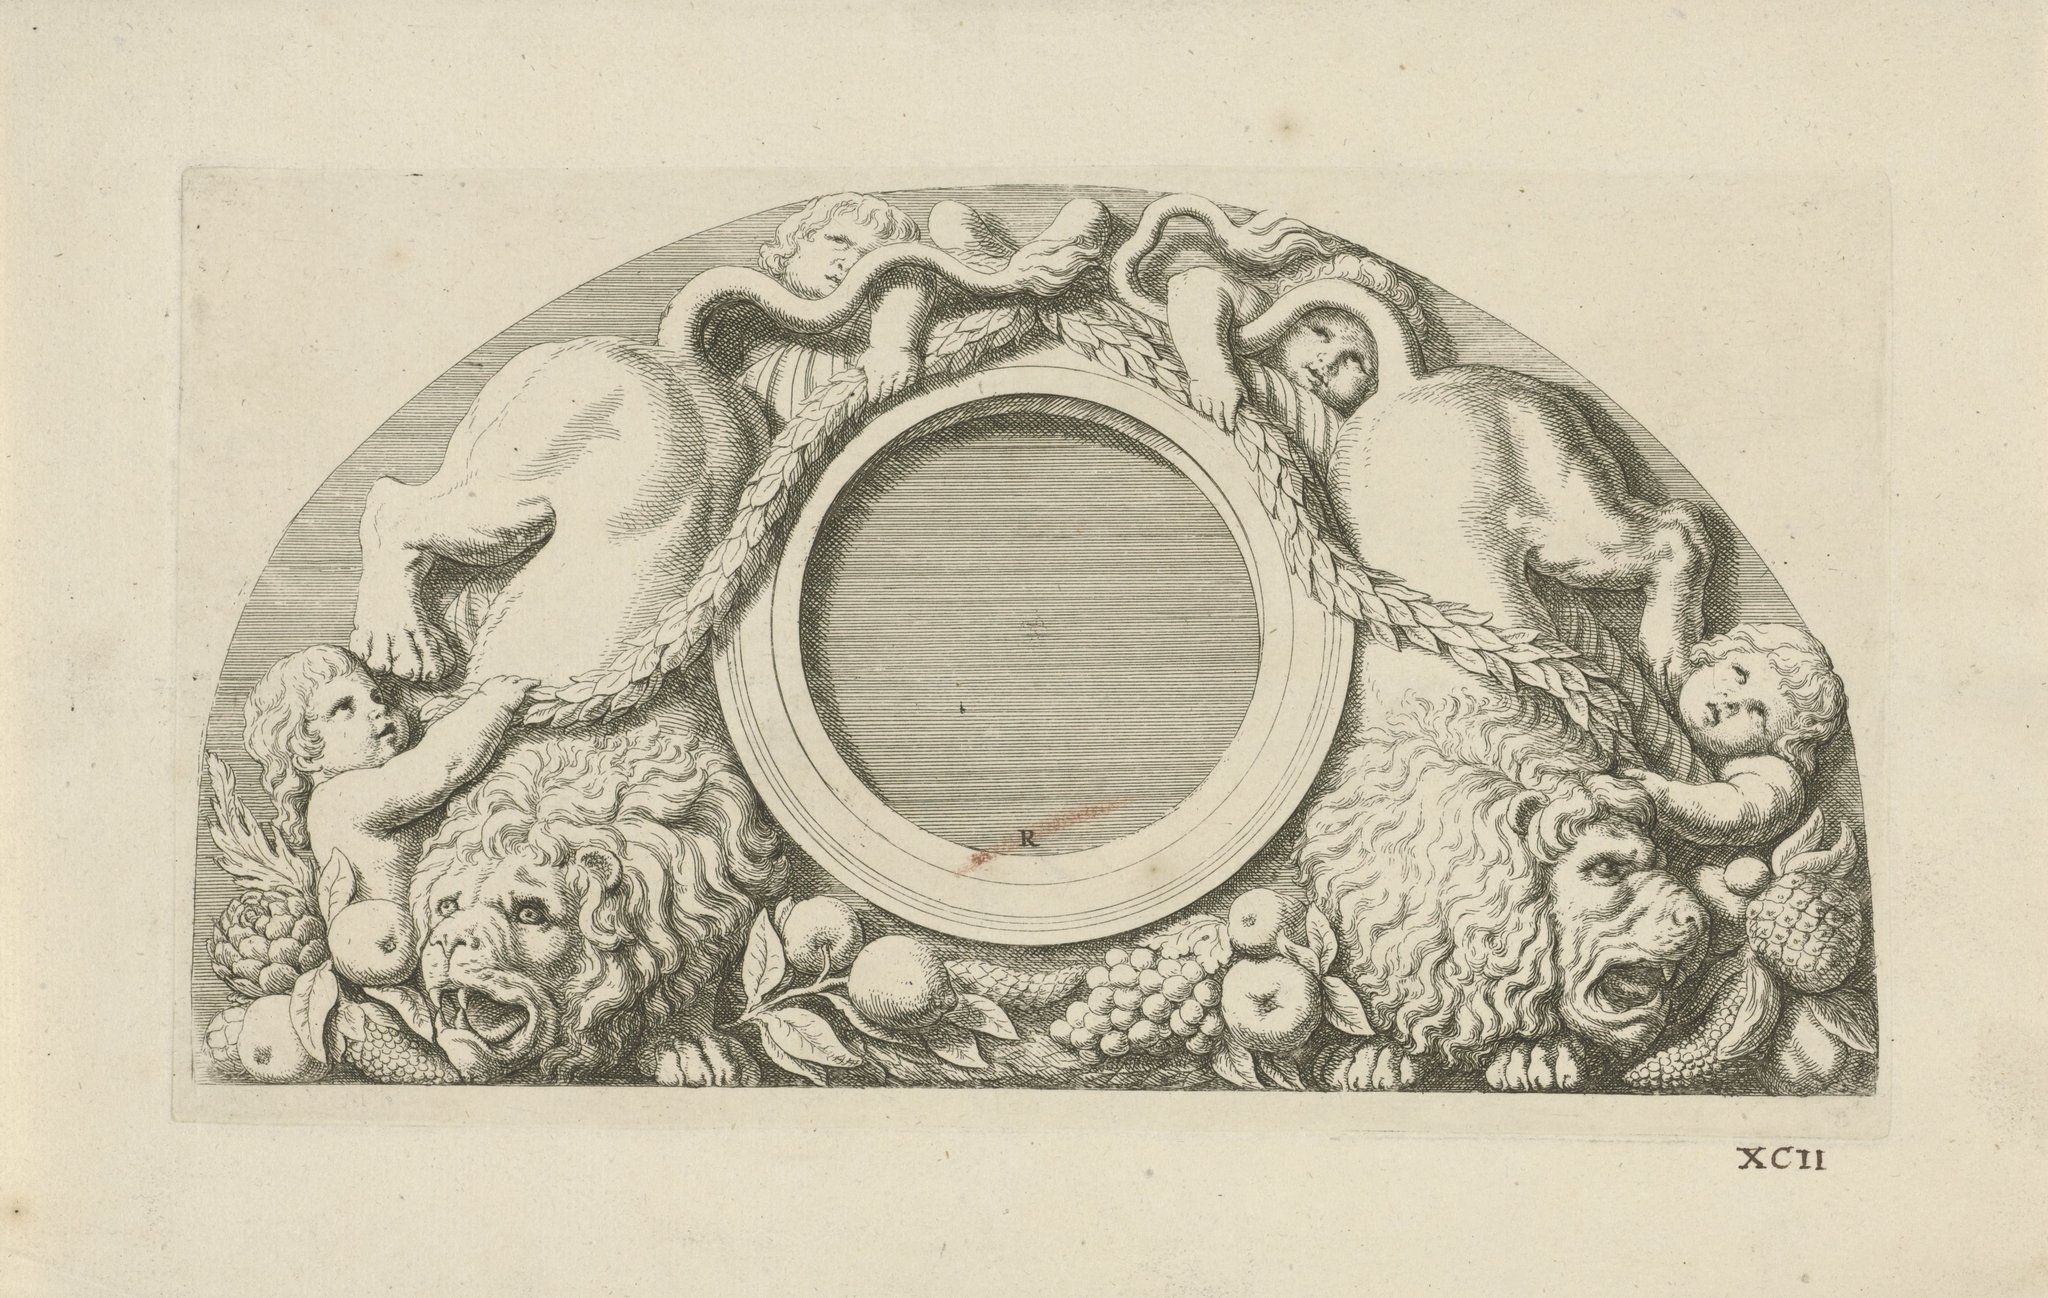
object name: print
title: Lunette met putti, leeuwen en hoornen des overvloeds in de oostelijke galerij van het Stadhuis op de Dam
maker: hubert quellinus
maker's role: print maker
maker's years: 1619-1687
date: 1655-1665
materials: chalk, ink, paper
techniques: engraving, etching, pen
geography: amsterdam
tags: 'cornucopia', horn of plenty, beasts of prey, predatory animals: lion, cupids: 'amores', 'amoretti', 'putti', attributes of cybele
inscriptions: inscription: ‘XCII’, collector's mark: Lugt 2228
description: Huidige staat van prent ook gebruikt in: Prima pars. Praecipuarum effigierum ac ornamentorum, amplissimae Curiae Amstelrodamensis (…) / Het eerste deel. Van de voornaemste Statuen ende Ciraten, vant konstijck Stadhuys van Amstelredam, tmeeste in marmer gemaeckt, door Artus Quellinus, Beelthouwer der voorseyde Stadt / La Premier Partie. De plusieurs Figures et ornements, de la Maison de Ville d'Amsterdam (…). Amsterdam: Artus Quellinus (I), 1655. En in: Prima pars. Praecipuarum effigierum ac ornamentorum, amplissimae Curiae Amstelrodamensis (…) / Het eerste deel. Van de voornaemste Statuen ende Ciraten, vant konstijck Stadhuys van Amstelredam, tmeeste in marmer gemaeckt, door Artus Quellinus, Beelthouwer der voorseyde Stadt / La Premier Partie. De plusieurs Figures et ornements, de la Maison de Ville d'Amsterdam (…). Amsterdam: Frederik de Wit, 1665. Latere staat van prent ook gebruikt in: Architecture peinture et sculpture de la Maison de Ville d'Amsterdam, representee en CIX. figures en taille-douce (…). Amsterdam: David Mortier, 1719. En in: Architecture peinture et sculpture de la Maison de Ville d'Amsterdam, representee en CIX. figures en taille-douce (…). Amsterdam: Gerard Valck, 1719. En in: Bouw schilder en beeldhouwkonst, van het Stadhuis te Amsteldam, vertoont in CIX figuuren (…). Amsterdam: Covens & Mortier & Covens Jr., s.a. (1774-1783).